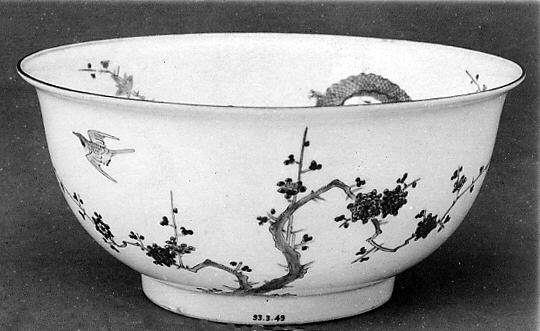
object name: bowl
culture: japanese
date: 1701-1800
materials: enamel, porcelain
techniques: overglaze, underglaze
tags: birds,trees